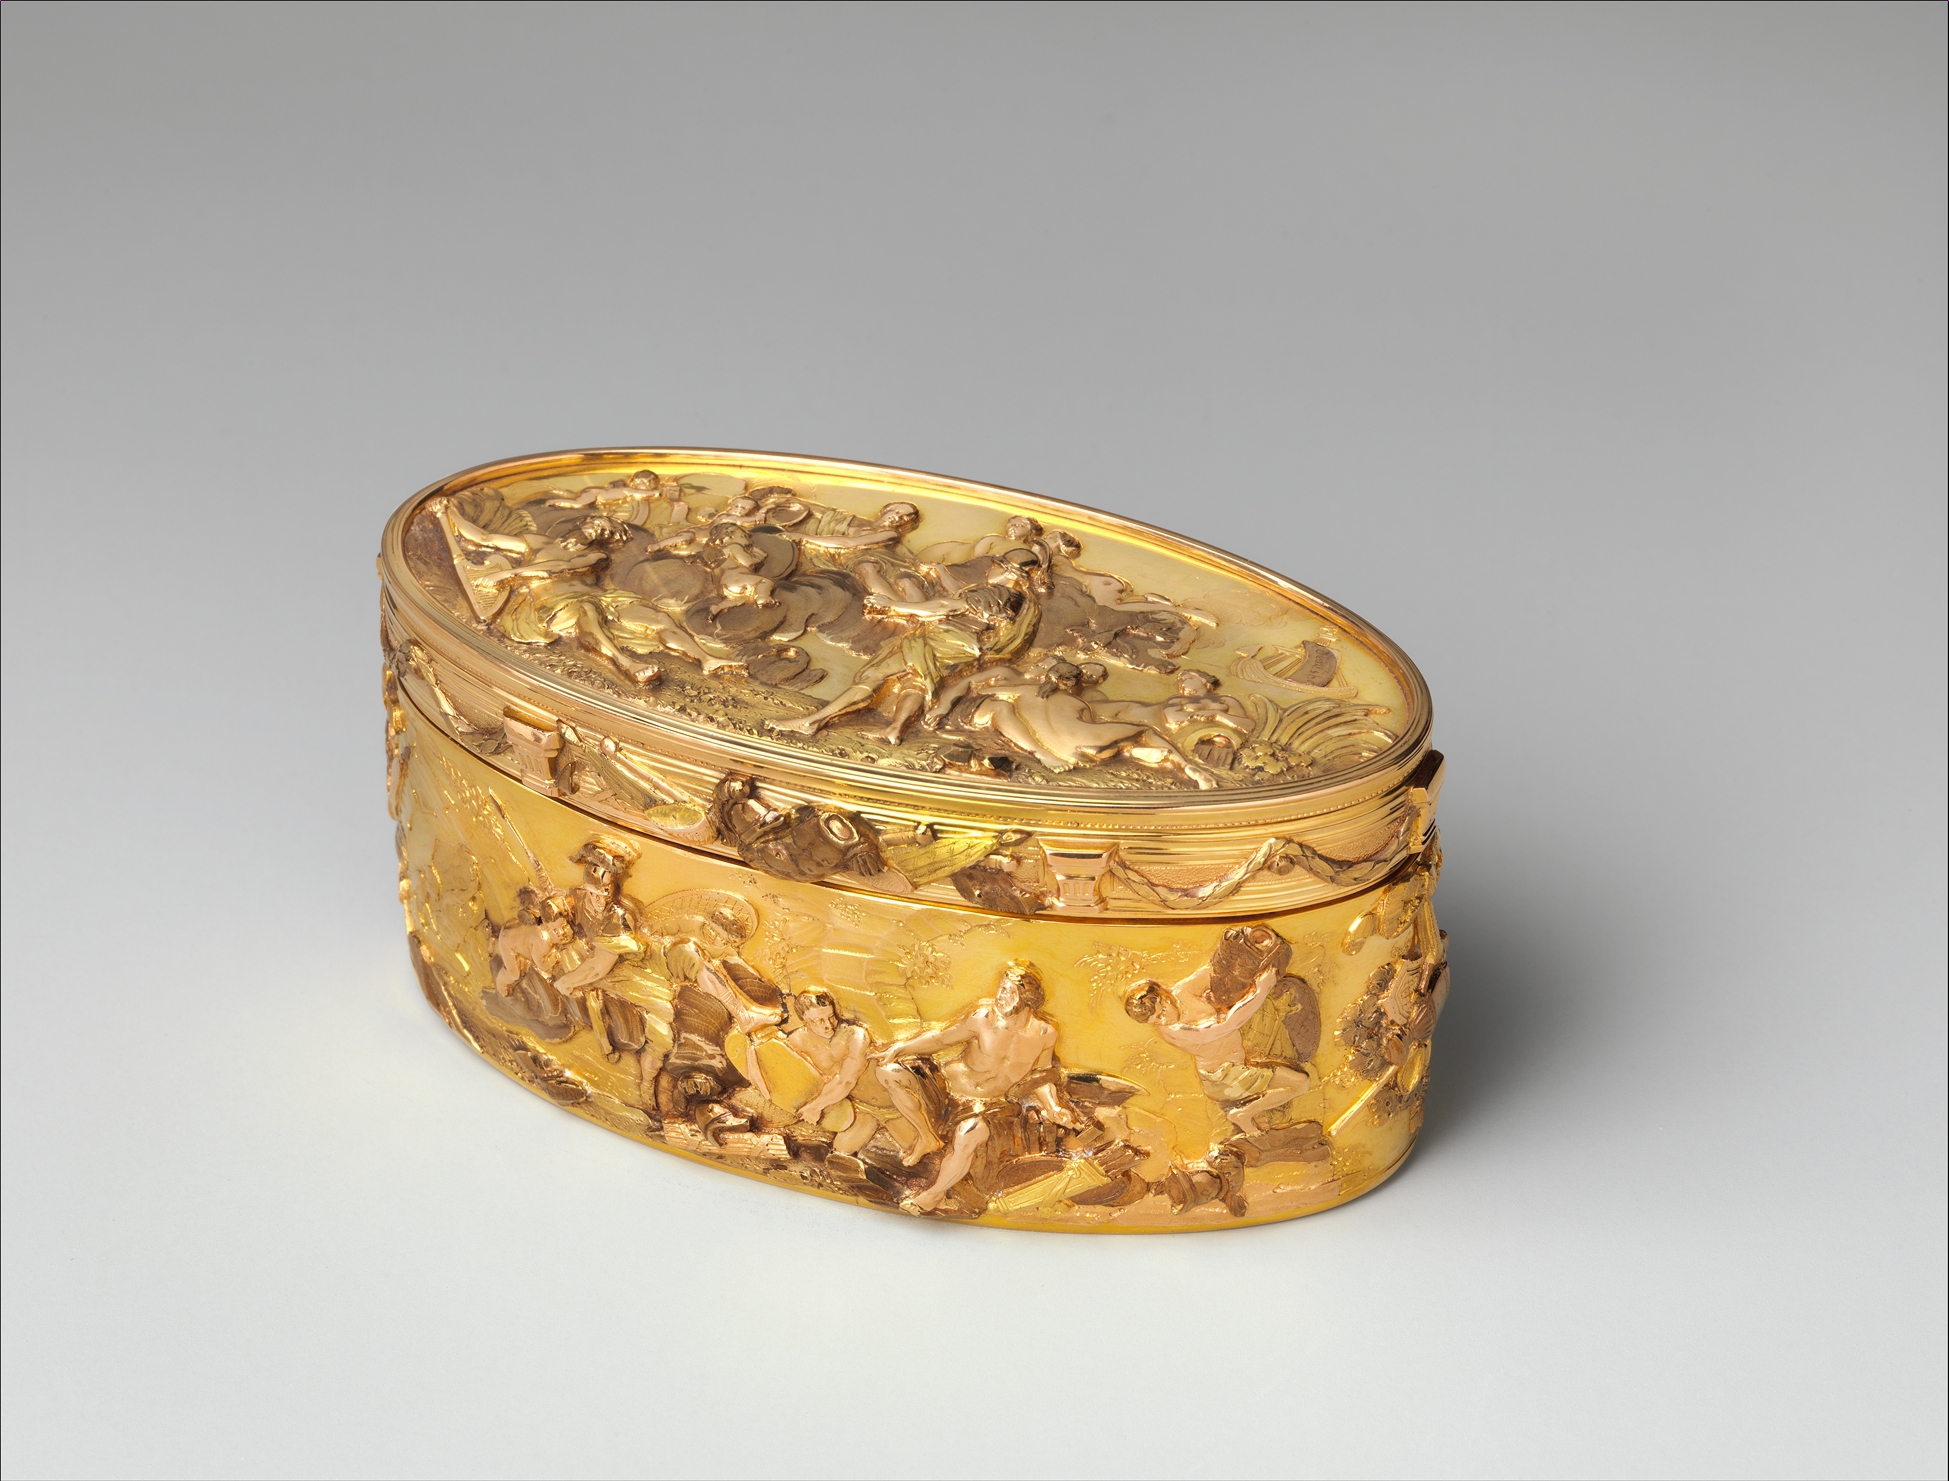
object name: snuffbox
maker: henry bodson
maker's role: maker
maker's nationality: french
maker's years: 1733-1819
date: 1768-1769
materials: gold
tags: children,men,women